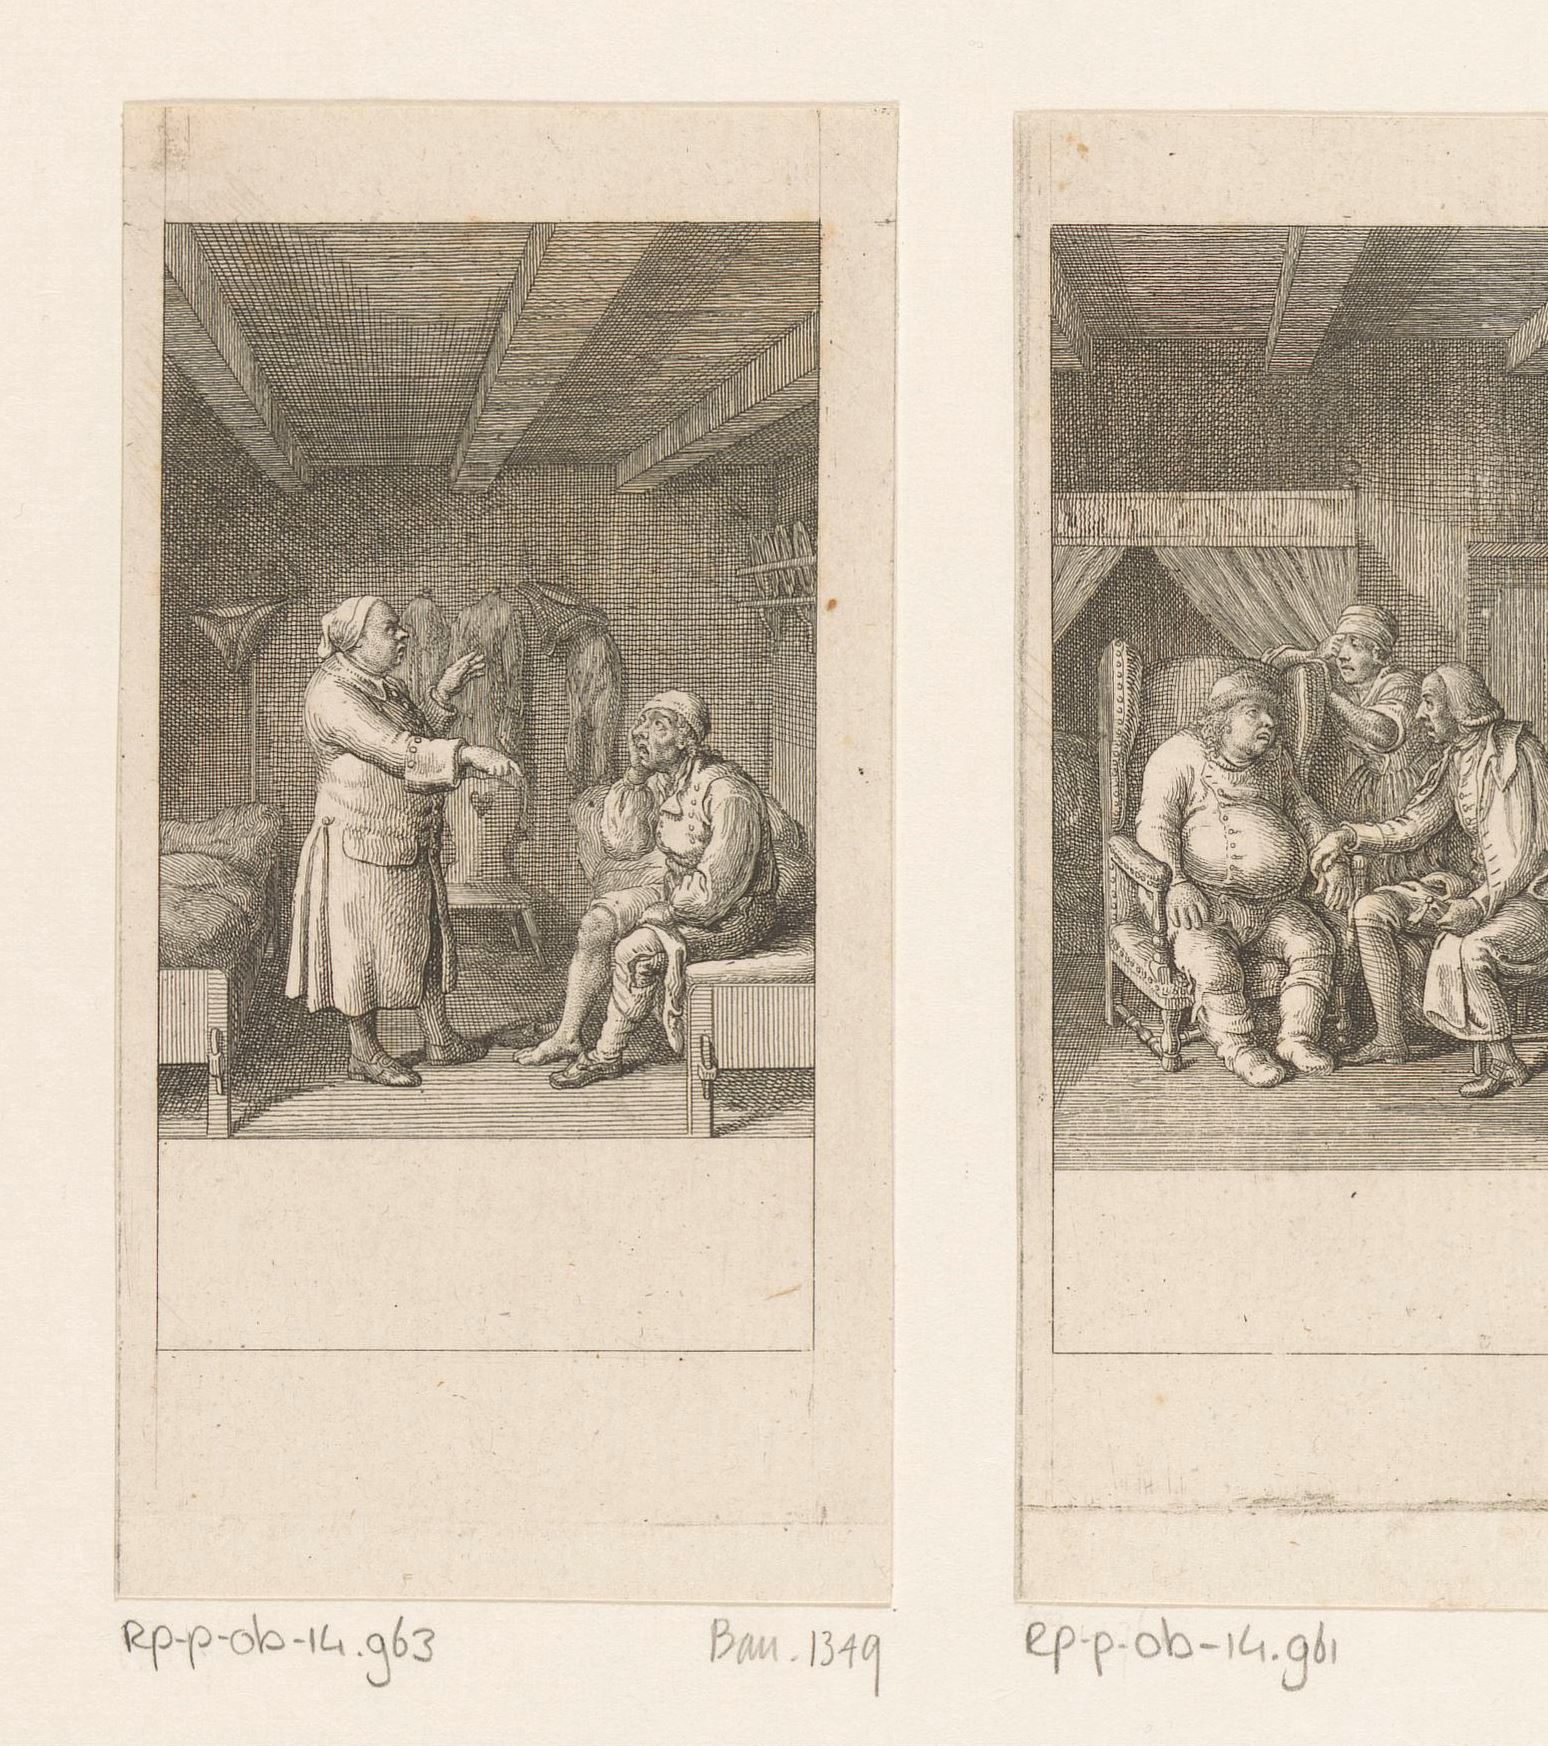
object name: print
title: Musefeld bekeert zijn vader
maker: daniel nikolaus chodowiecki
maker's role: draughtsman, print maker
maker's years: 1726-1801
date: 1788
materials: paper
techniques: etching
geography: berlin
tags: father and son(s) (family group), conversion and belief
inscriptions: collector's mark: Lugt 2228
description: Vervaardigd voor een serie over Duitse rages. Latere staat gebruikt voor: Berliner genealogischen Calender auf das Jahr 1789. [Berlijn]: s.n., [1788].